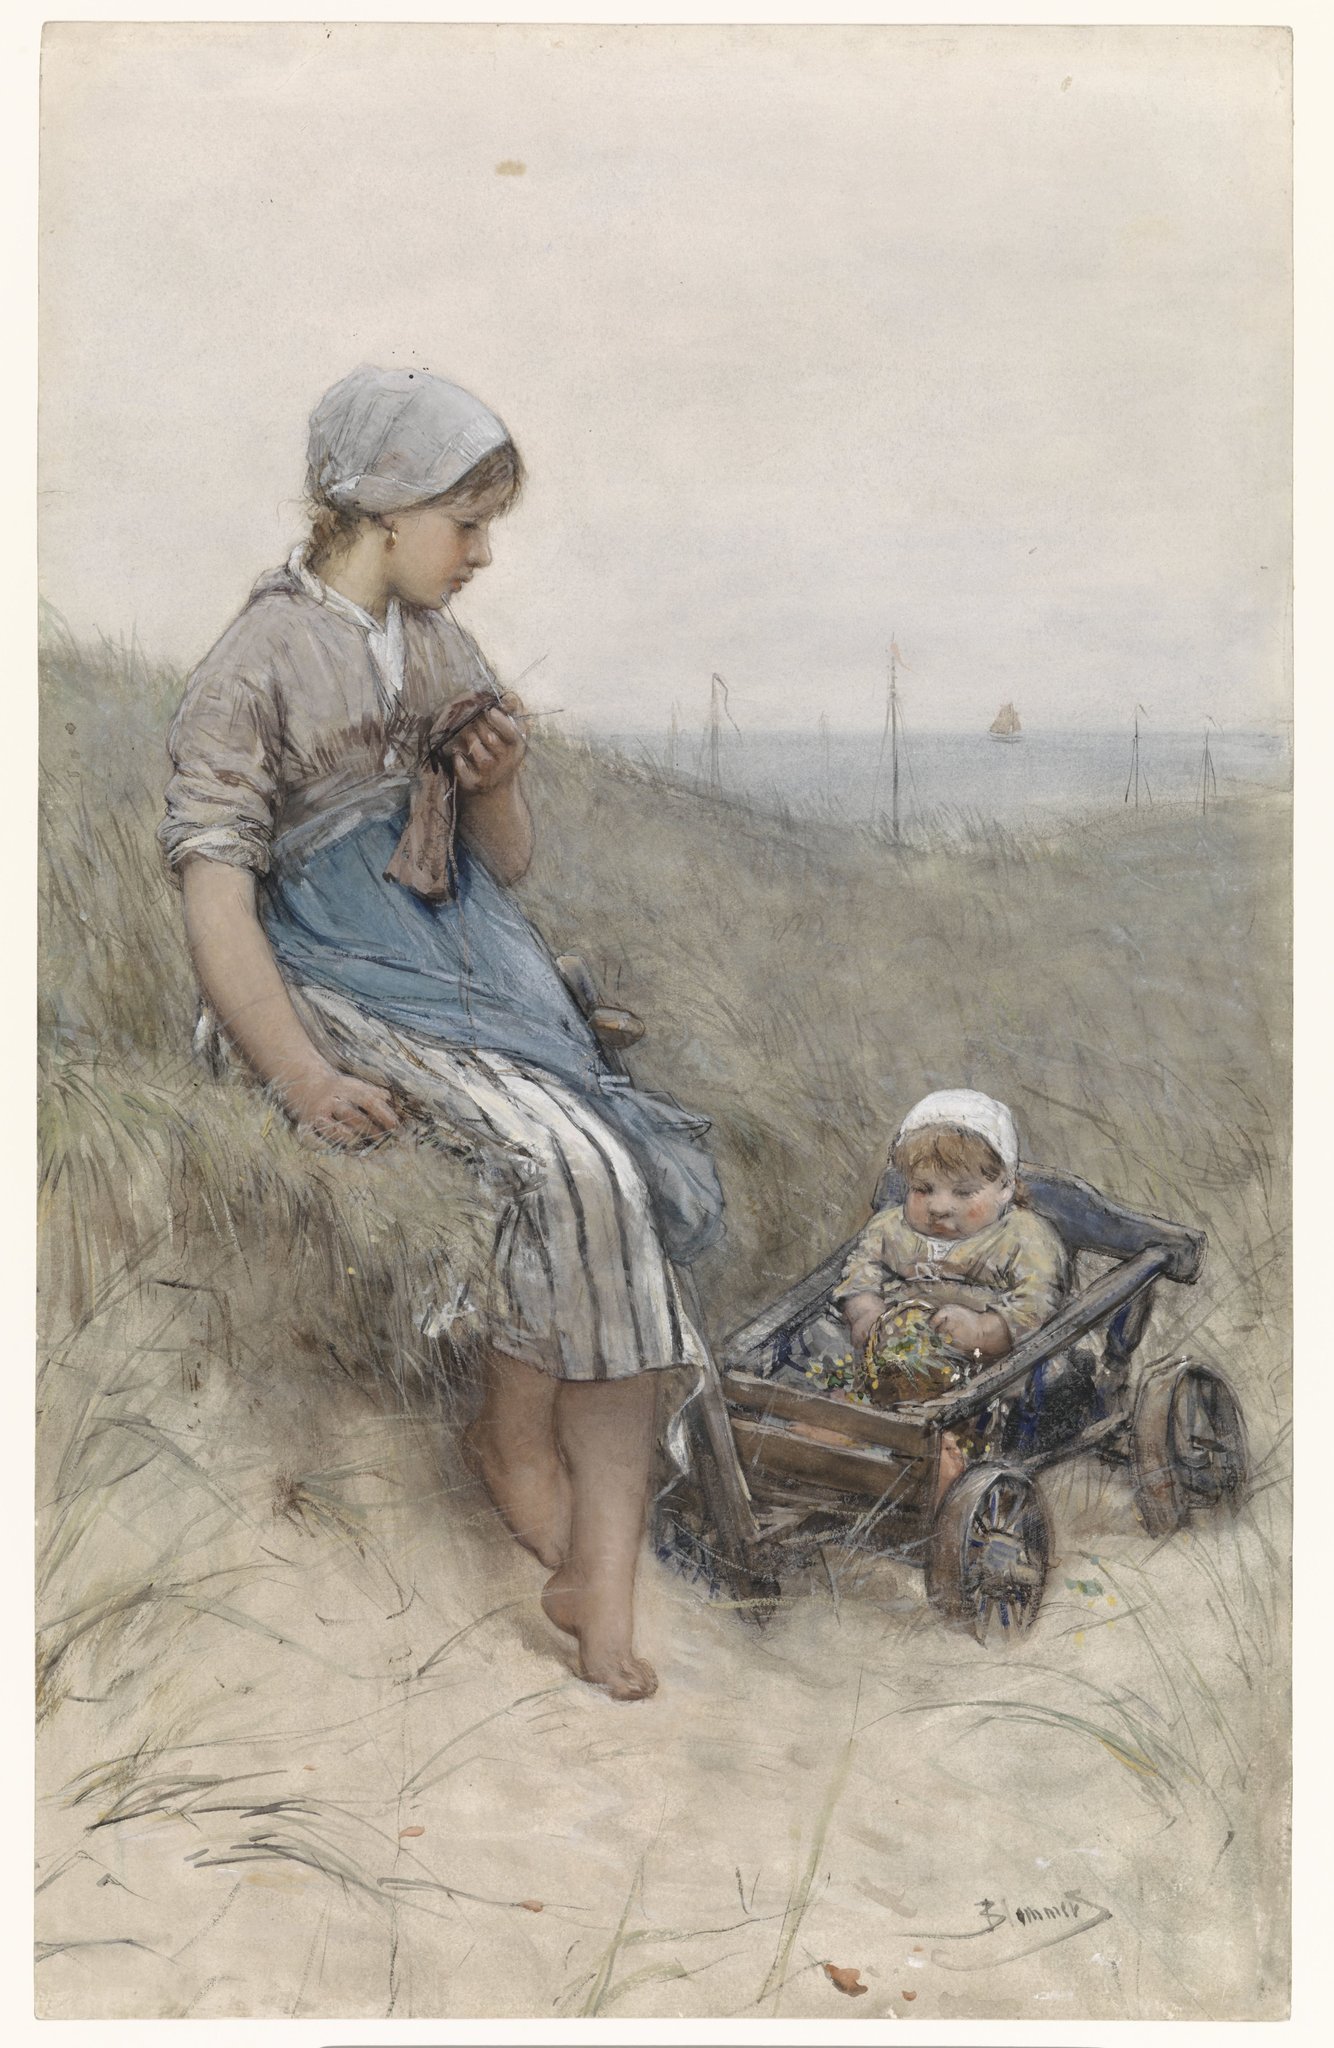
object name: watercolor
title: Vissersmeisje met kind in kinderwagen in de duinen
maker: bernardus johannes blommers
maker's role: draughtsman, print maker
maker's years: 1845-1914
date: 1880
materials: chalk, paint, paper, watercolor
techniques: brush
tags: baby-carriage, pram, perambulator, taking care of children - aa - by other children, dunes (sea not visible); in the dunes